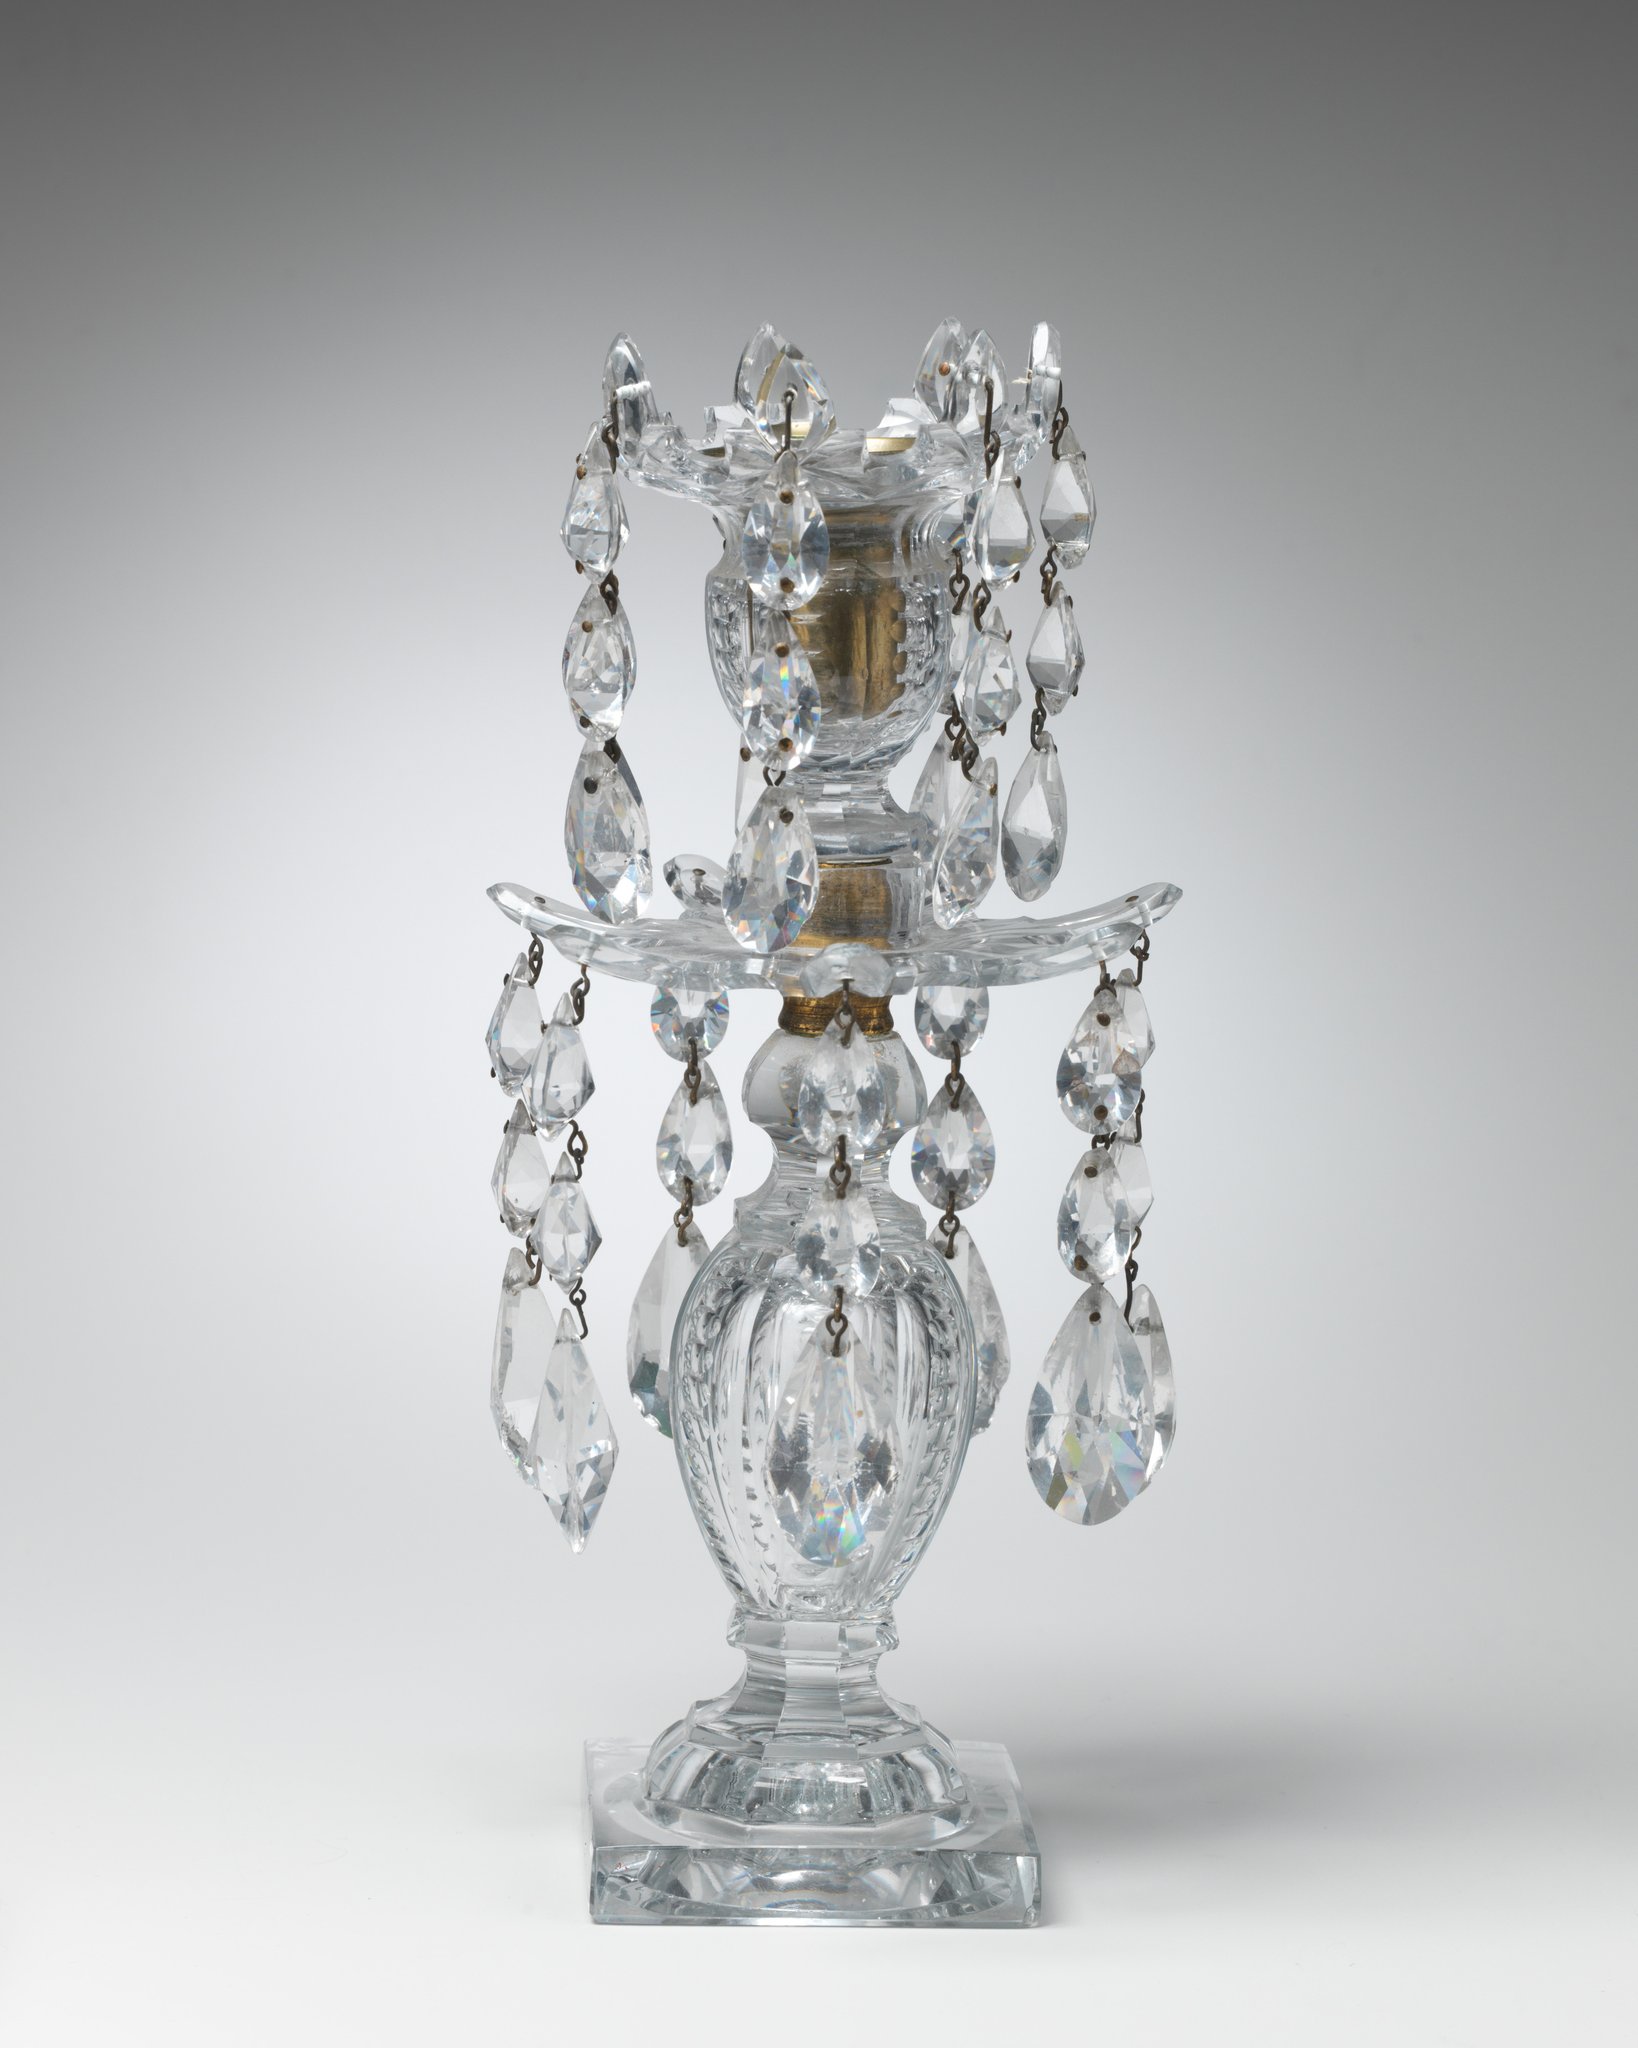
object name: candlestick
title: Candlestick (one of a pair)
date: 1785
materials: glass